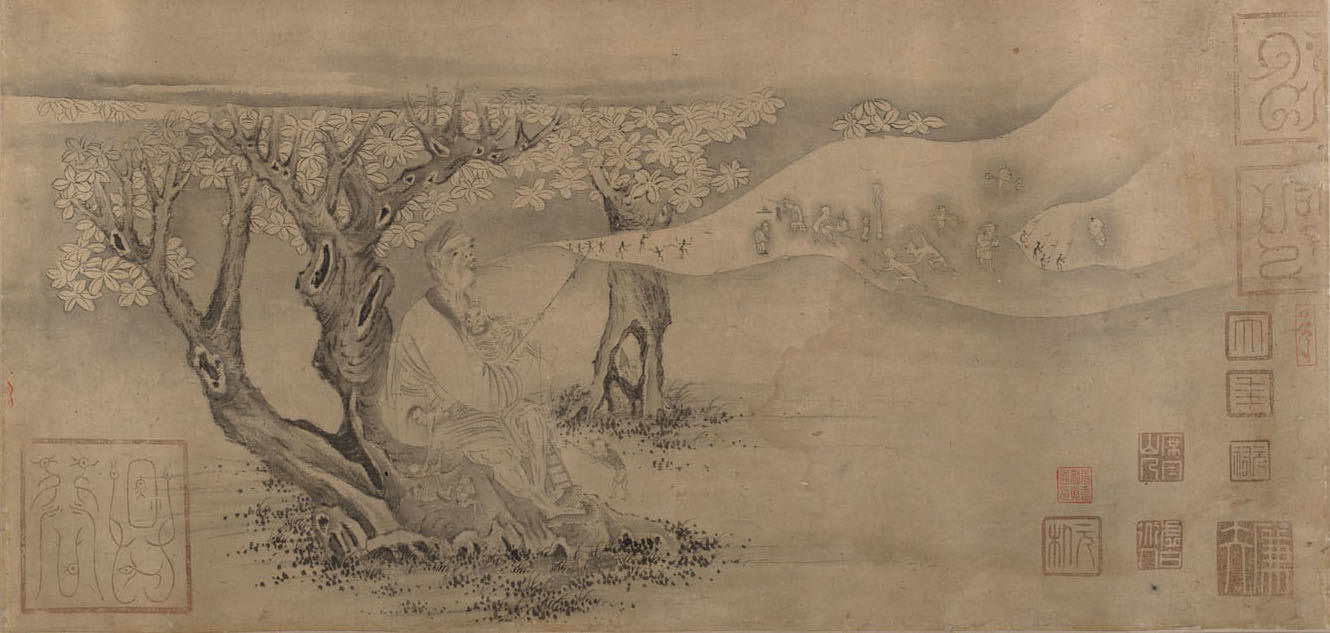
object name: handscroll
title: Demon Exorcisor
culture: chinese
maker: unidentified artist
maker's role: artist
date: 1368-1911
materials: ink, paper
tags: men,demons